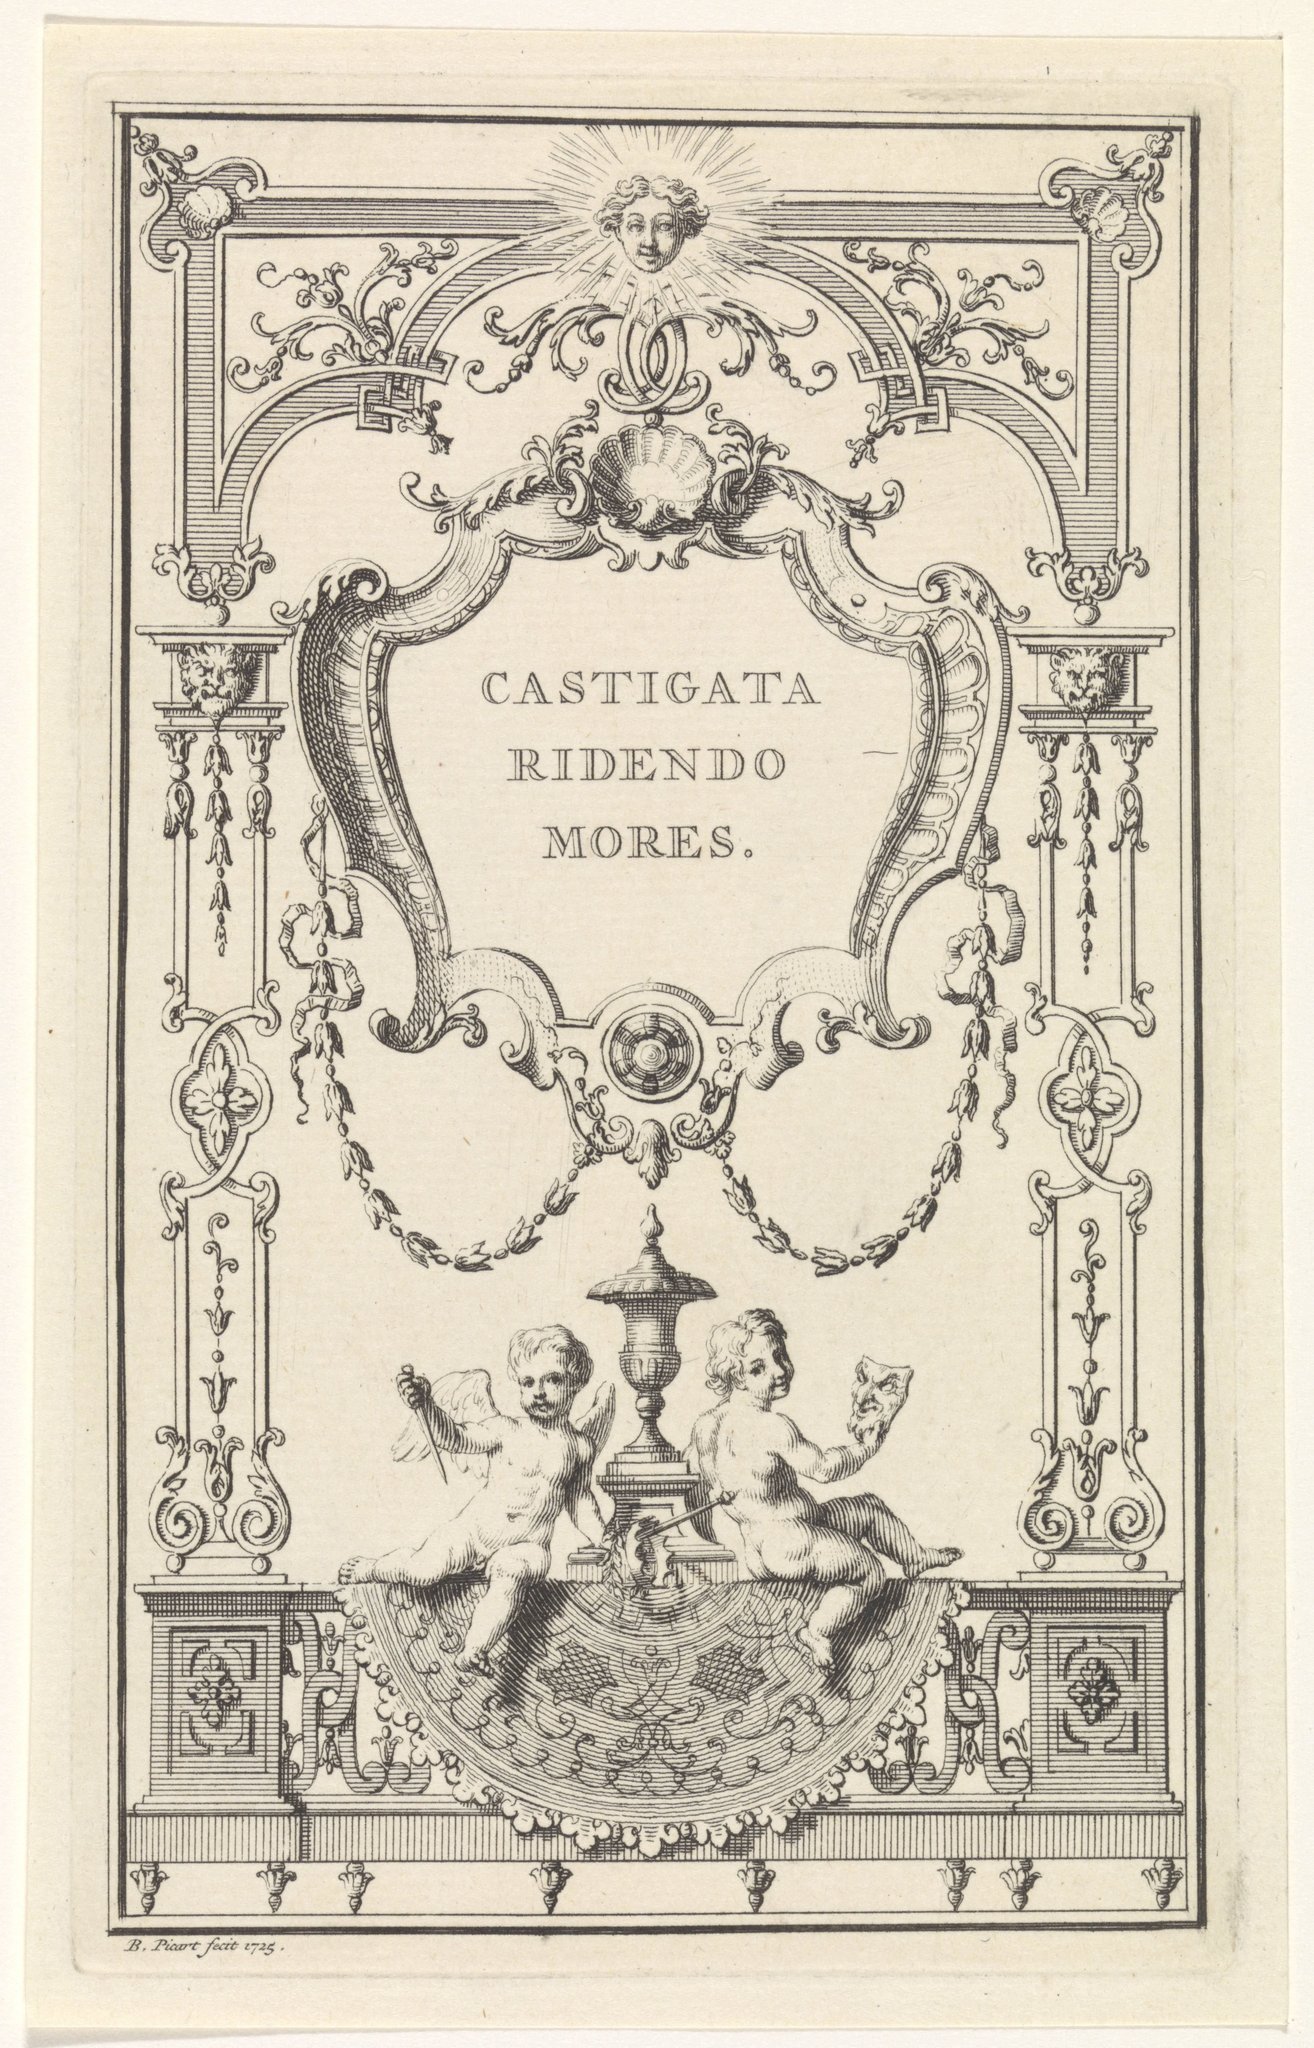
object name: titelblad, titelpagina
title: Titelpagina met verwijzingen naar theater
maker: bernard picart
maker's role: draughtsman, print maker, publisher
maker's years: 1673-1733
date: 1725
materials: paper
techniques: engraving, etching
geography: amsterdam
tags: symbolic representations, allegories and emblems ~ the theatre, ornament ~ geometric motifs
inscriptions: collector's mark: Lugt 2228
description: Ornamentele omlijsting met in het midden een cartouche waarin de titel in het Latijn (een citaat van Jean de Santeuil). Onderaan twee putti met in de handen attributen die verwijzen naar het theater.